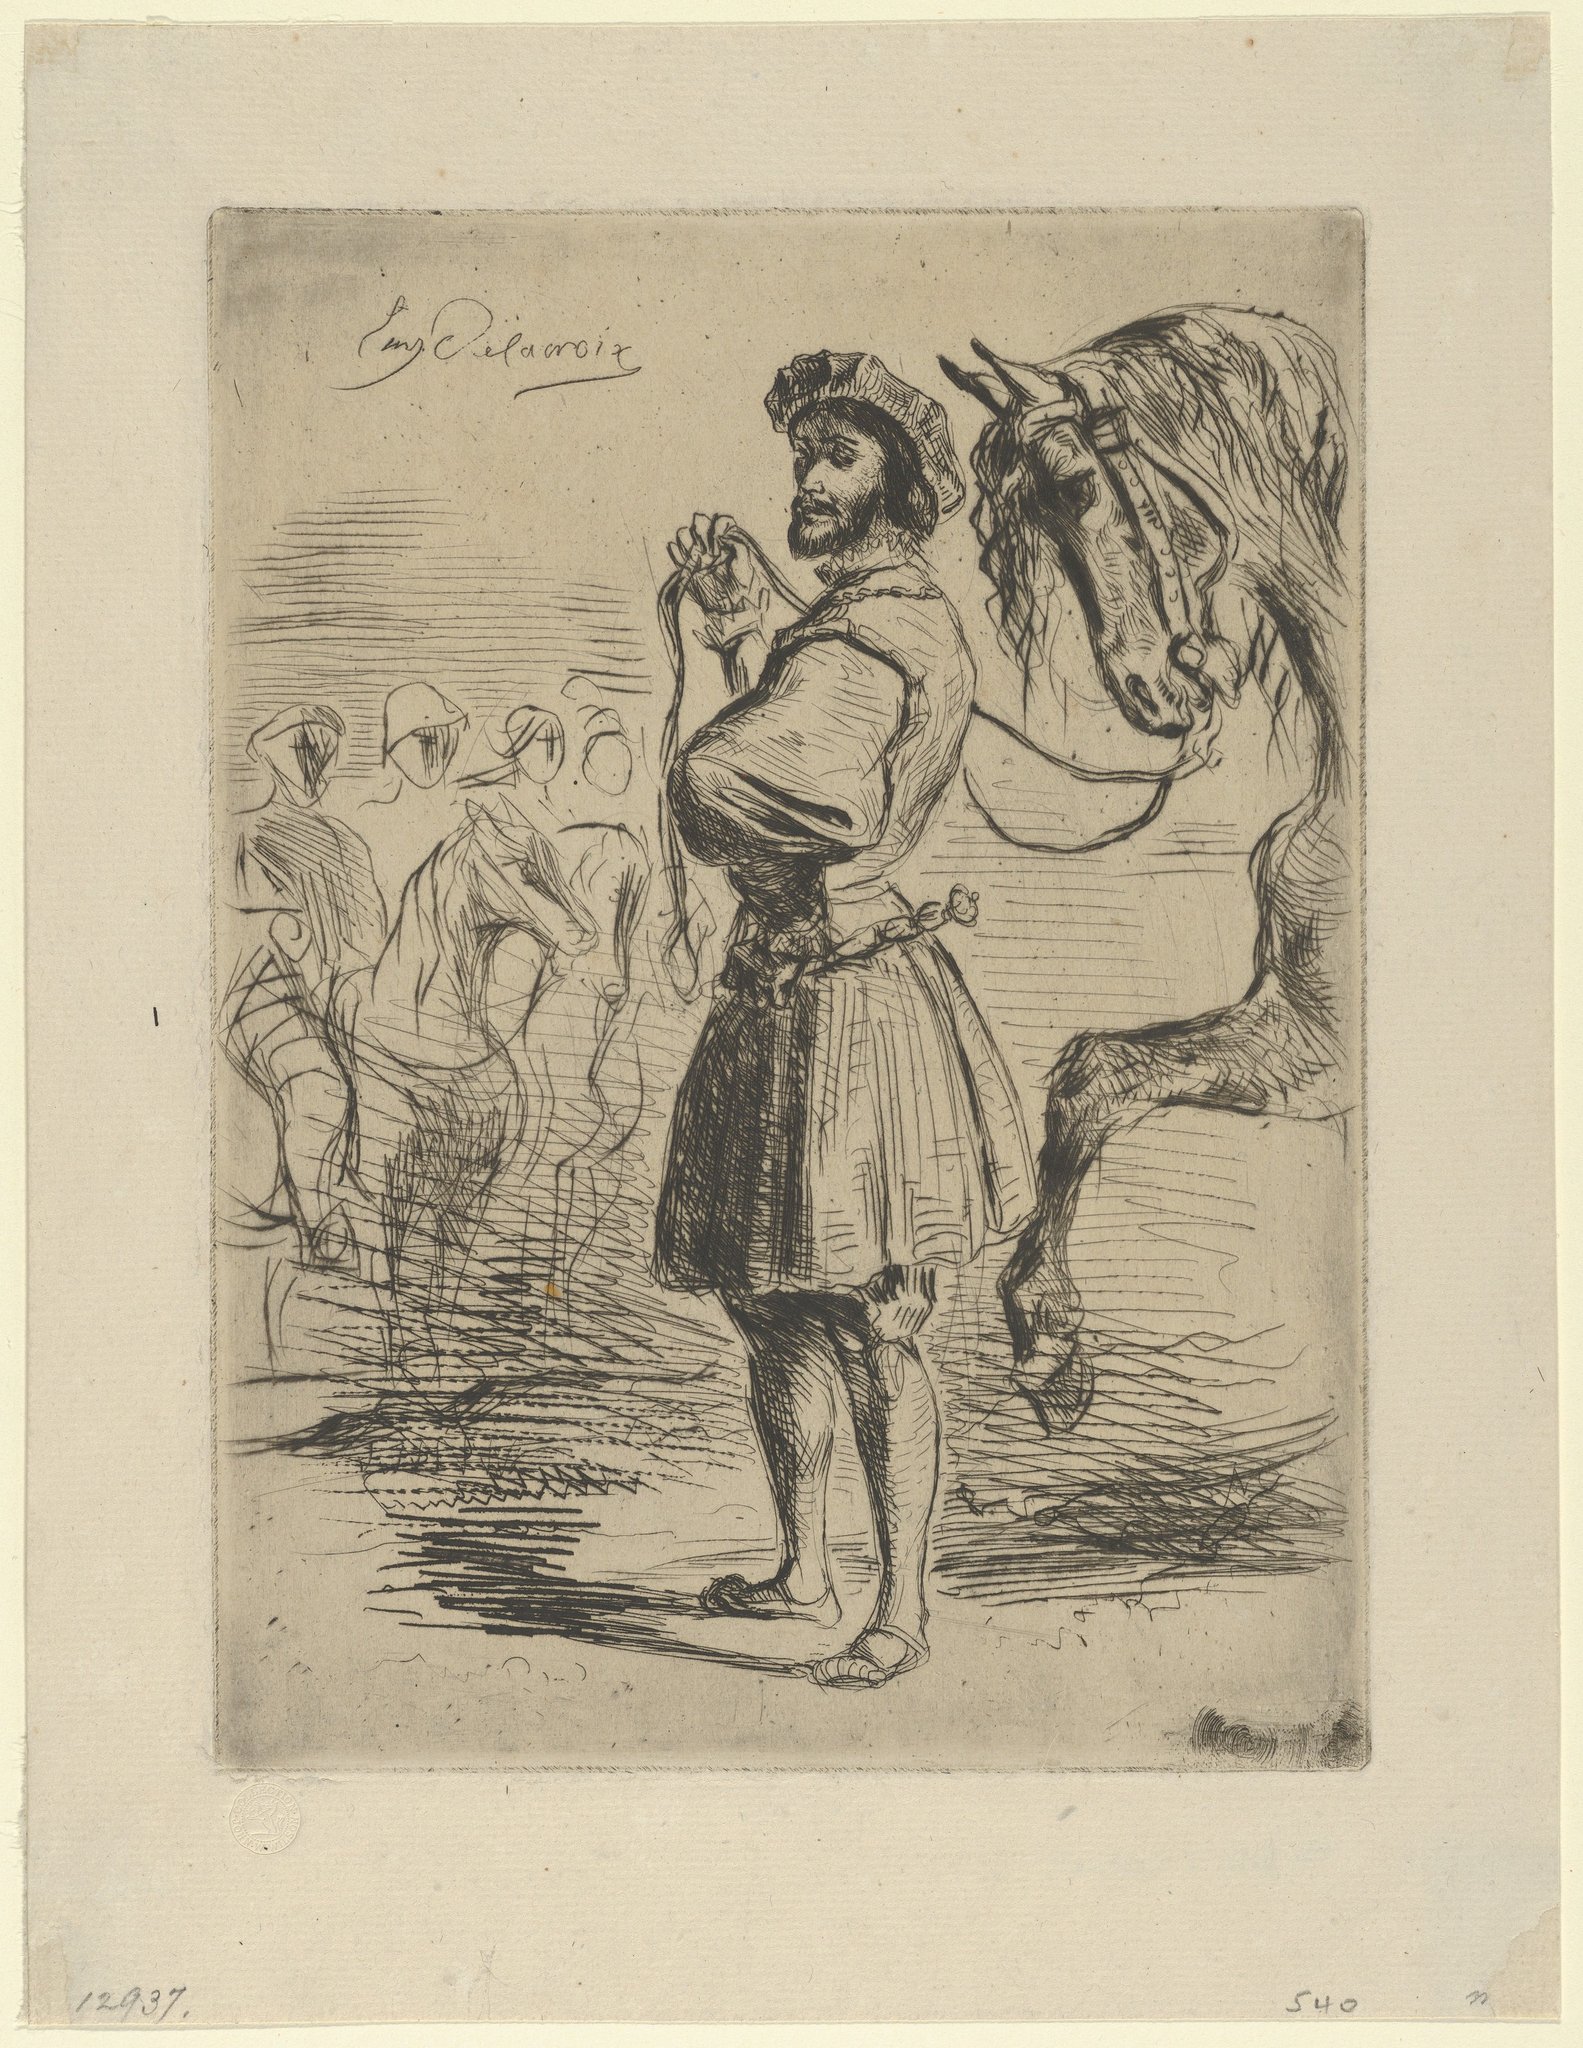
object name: print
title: A Nobleman from the Time of Francis I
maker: eugène delacroix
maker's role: artist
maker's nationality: french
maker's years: 1798-1863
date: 1833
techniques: drypoint, etching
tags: men,horses